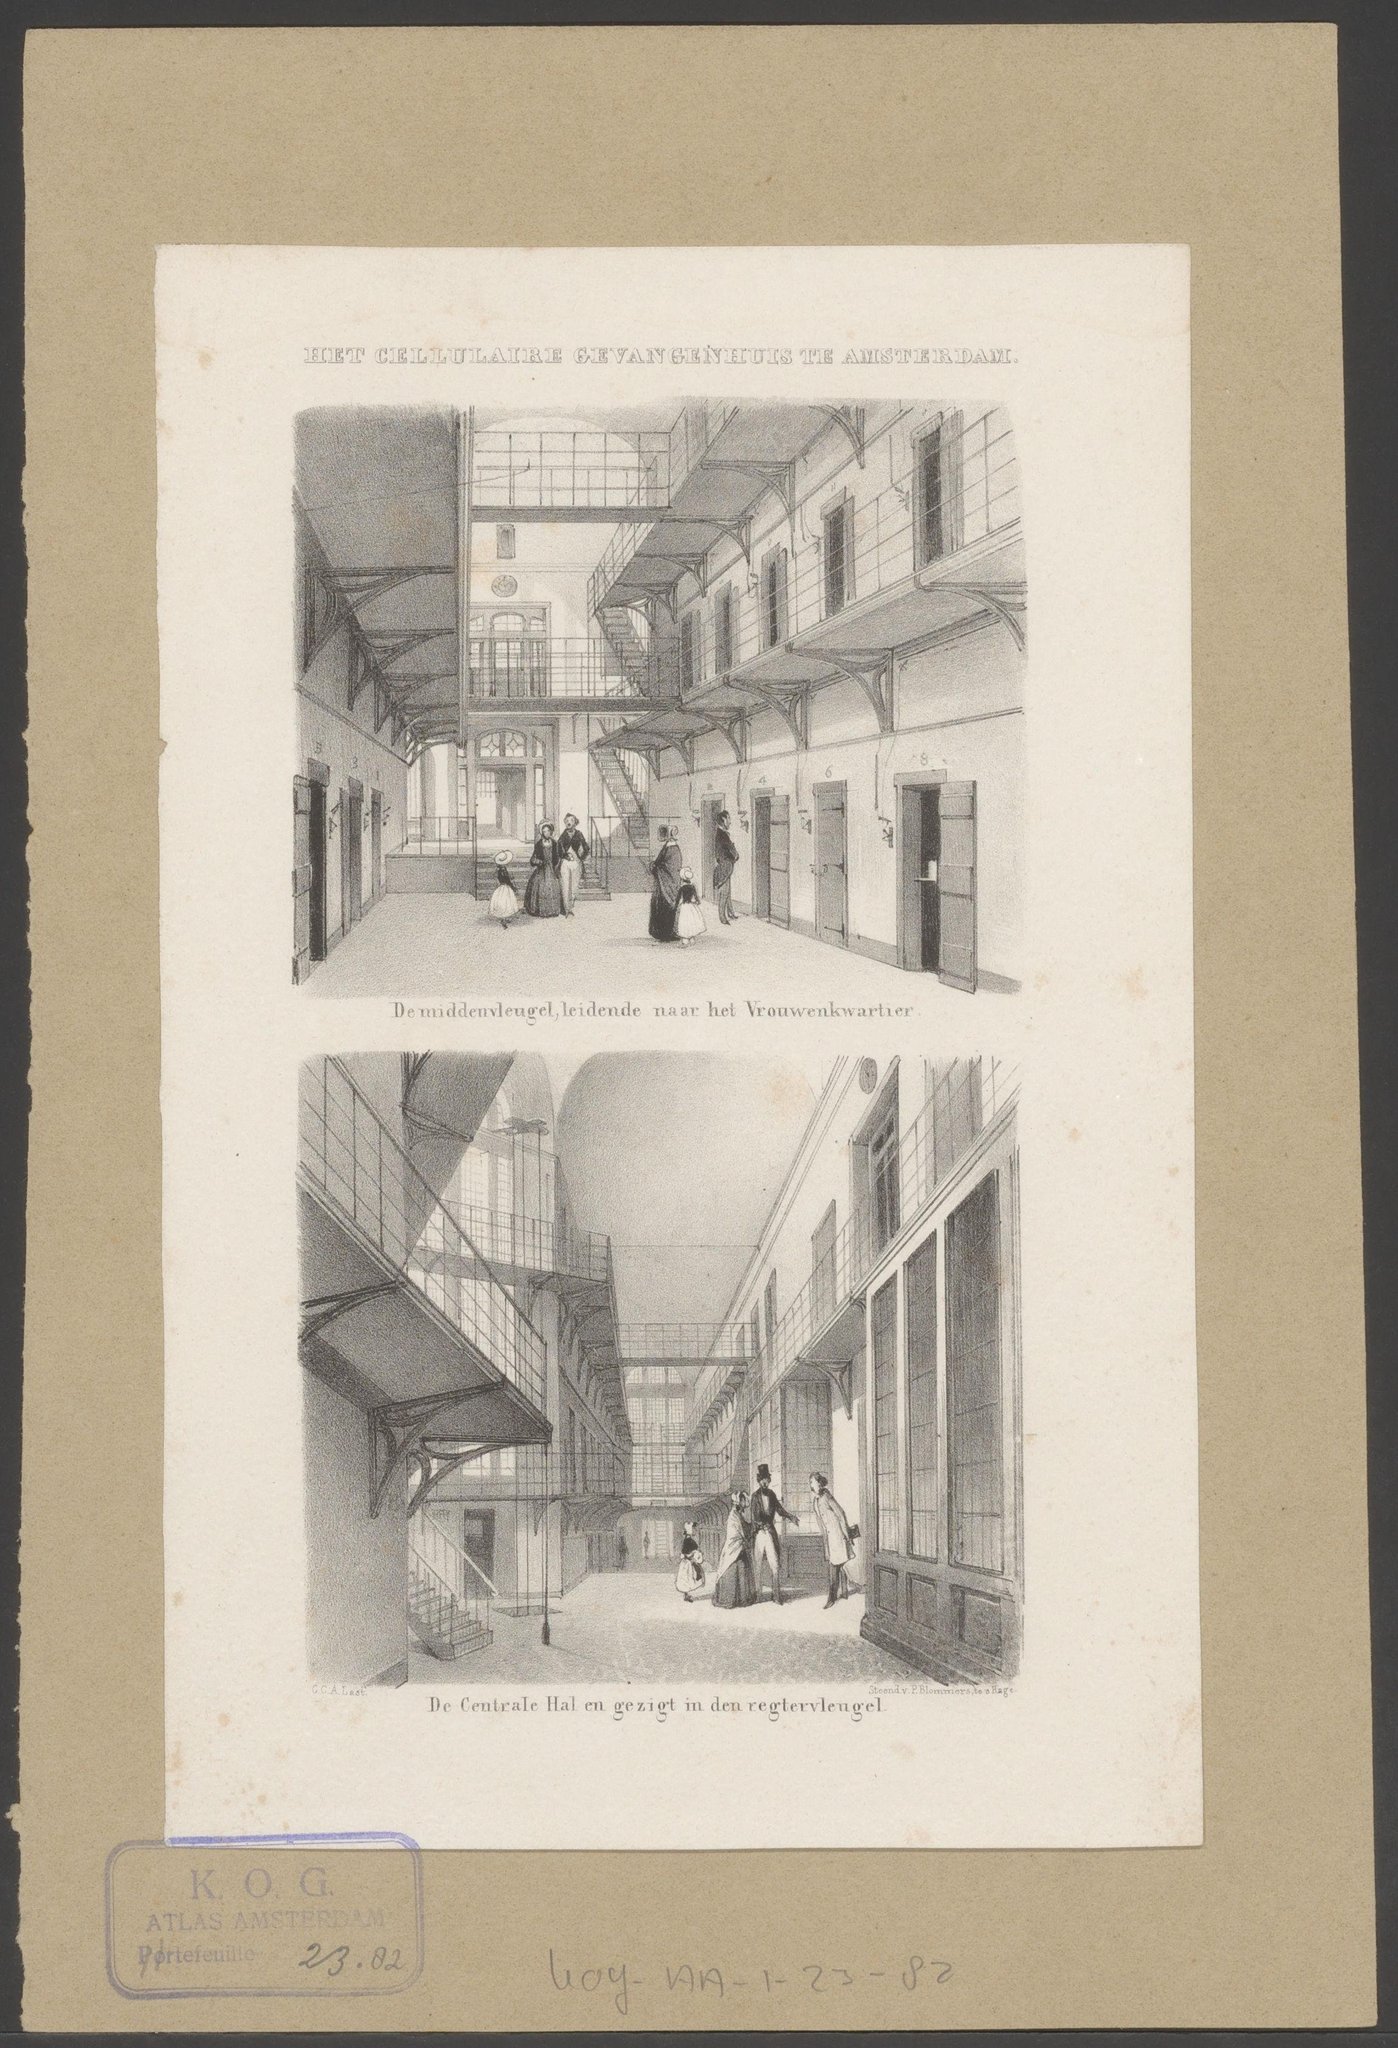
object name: print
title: Interieur van de gevangenis aan de Weteringschans te Amsterdam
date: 1848-1849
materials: paper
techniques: lithograph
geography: netherlands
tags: prison, jail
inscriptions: collector's mark: Lugt 1641b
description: Twee gezichten binnen in het net voltooide Huis van Bewaring aan de Weteringschans te Amsterdam, 1848. Boven de middenvleugel leidend naar het vrouwenkwartier, onder de centrale hal in de rechtervleugel. Onderwerpsrubriek binnen de Atlas Amsterdam: Rechtswezen.